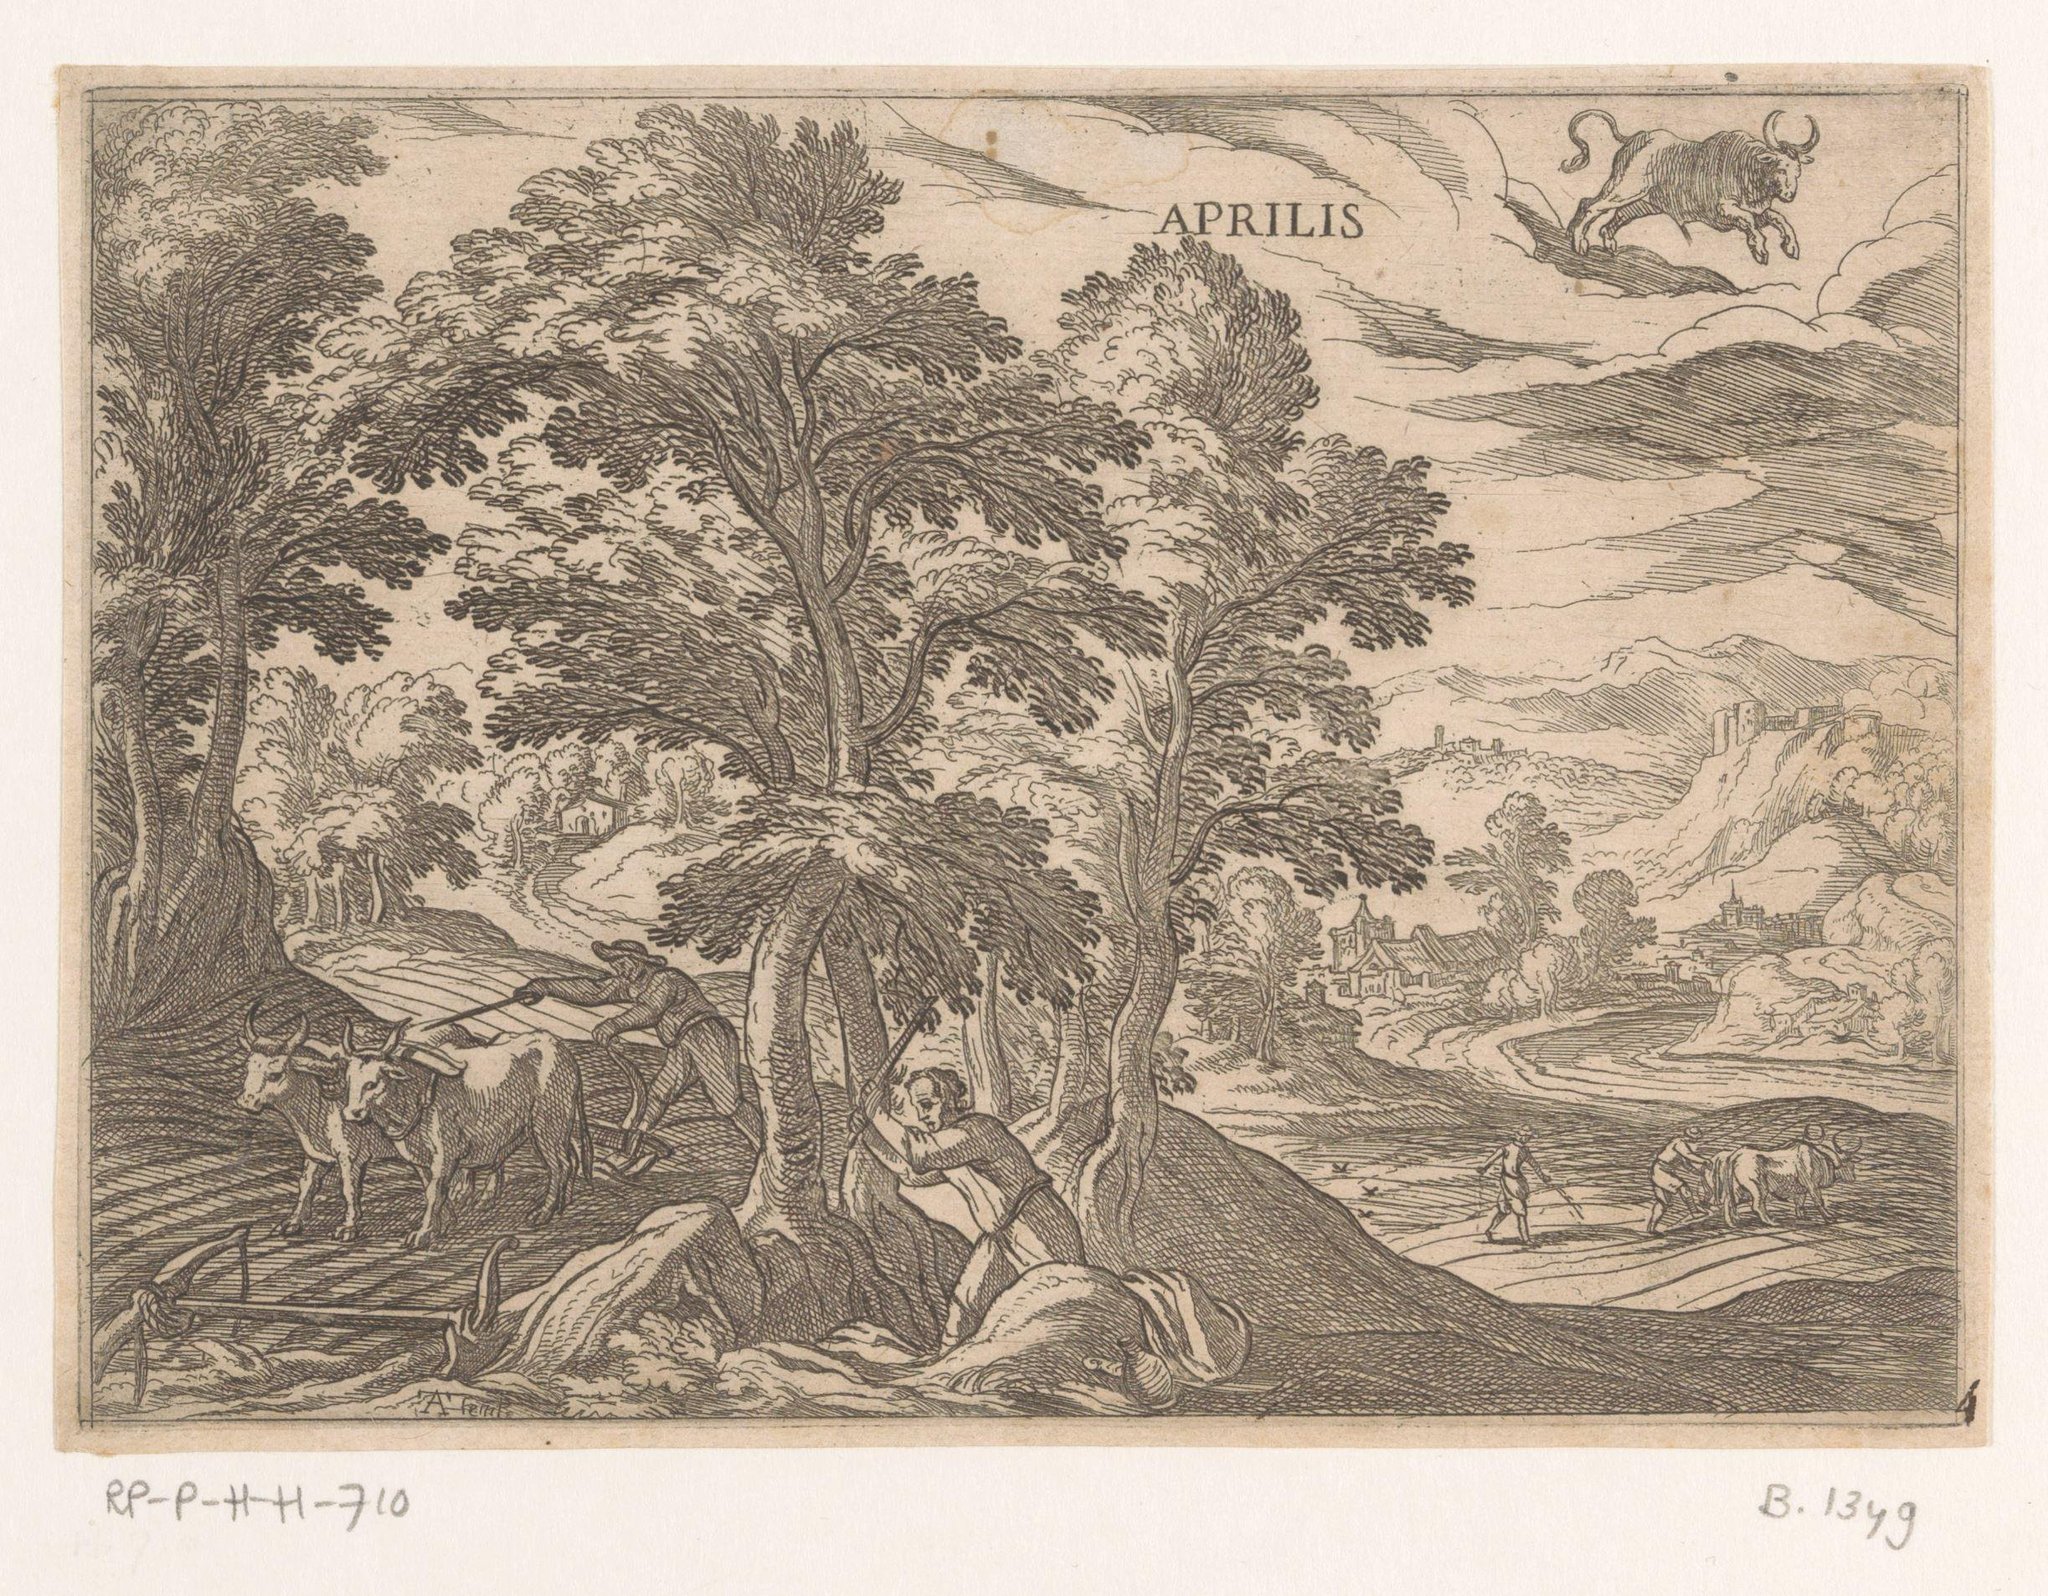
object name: print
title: Aprilis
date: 1575-1613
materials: paper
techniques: etching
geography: italy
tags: landscape symbolizing april, taurus (zodiacal sign of april), sowing, ploughing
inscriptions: collector's mark: ‘Hinloopen’, collector's mark: Lugt 11, number: ‘4’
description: Landschap dat de maand april verbeeldt. Landschap met boeren die zaaien en ploegen. Rechtsboven het symbool voor het sterrenbeeld stier.